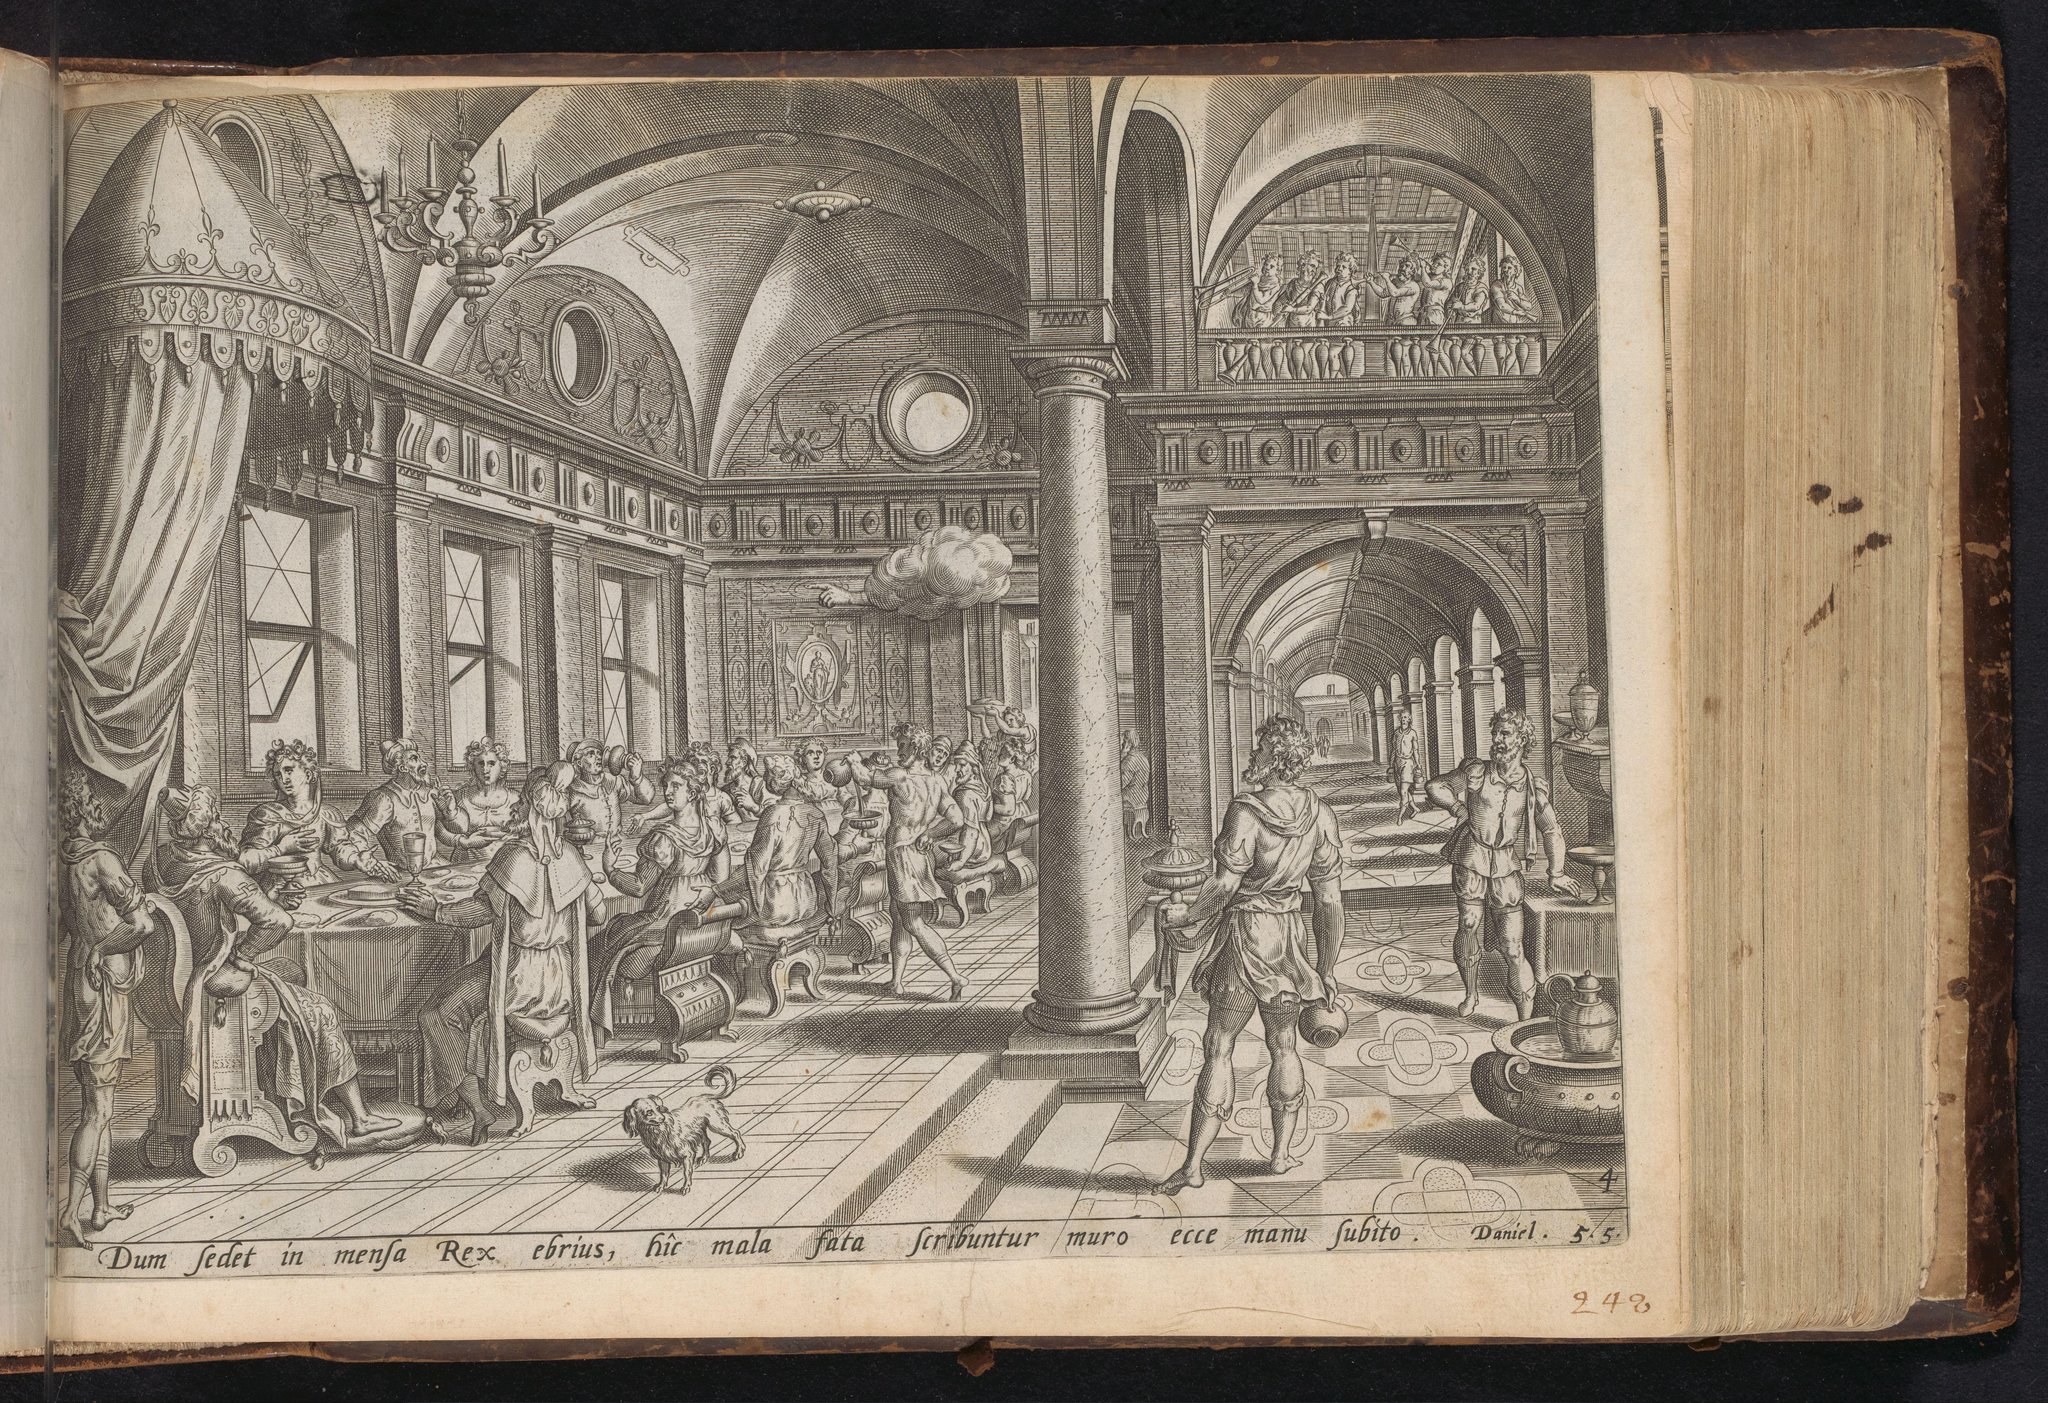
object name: album leaf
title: Feestmaal van Belsassar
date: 1646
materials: paper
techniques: engraving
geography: amsterdam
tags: during belshazzar's banquet a hand appears and writes on the wall (mene, mene, tekel and parsin (upharsin)); king belshazzar is frightened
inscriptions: number: ‘248’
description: Het feestmaal van Belsassar, koning van Babylon, met zijn hovelingen en vrouwen. Belsassar, op de rug gezien aan het hoofd van de tafel, ziet een schrijvende hand verschijnen. Op tafel staan de gestolen bekers en schalen uit de tempel van Jeruzalem. Rechtsboven staan trompetters op het balkon. Onder de voorstelling een verwijzing in het Latijn naar de Bijbeltekst in Dan. 5:5. Deze prent maakt deel uit van een album.